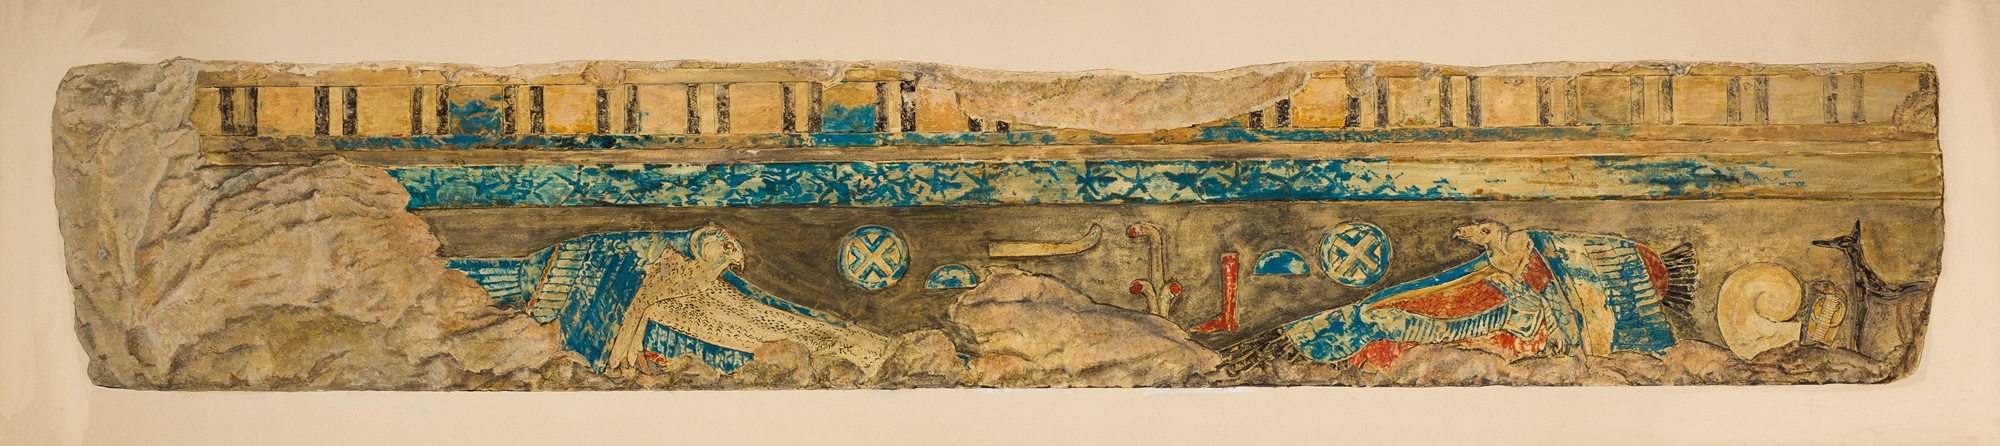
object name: facsimile, pyramid temple of amenemhat i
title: Relief Fragment, Pyramid Temple of Amenemhat I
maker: grace a. luther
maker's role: artist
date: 1981-1952 BCE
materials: paper, paint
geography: egypt